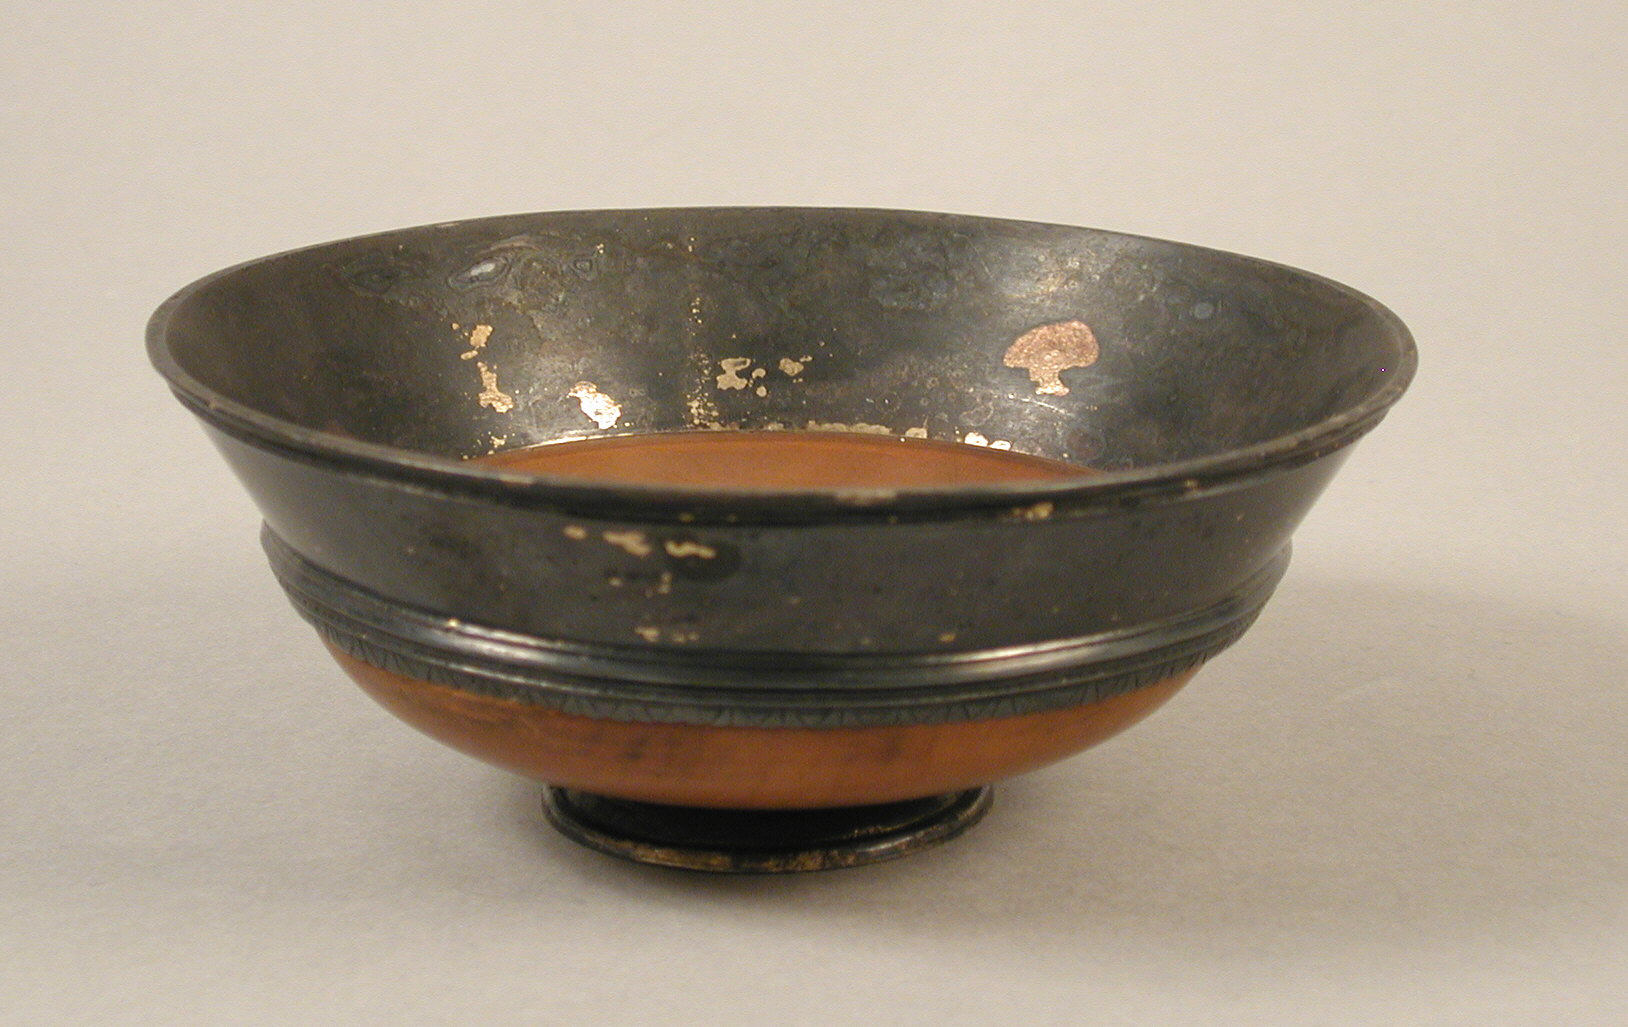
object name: mazer bowl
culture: british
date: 1901-1933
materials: wood, silver gilt